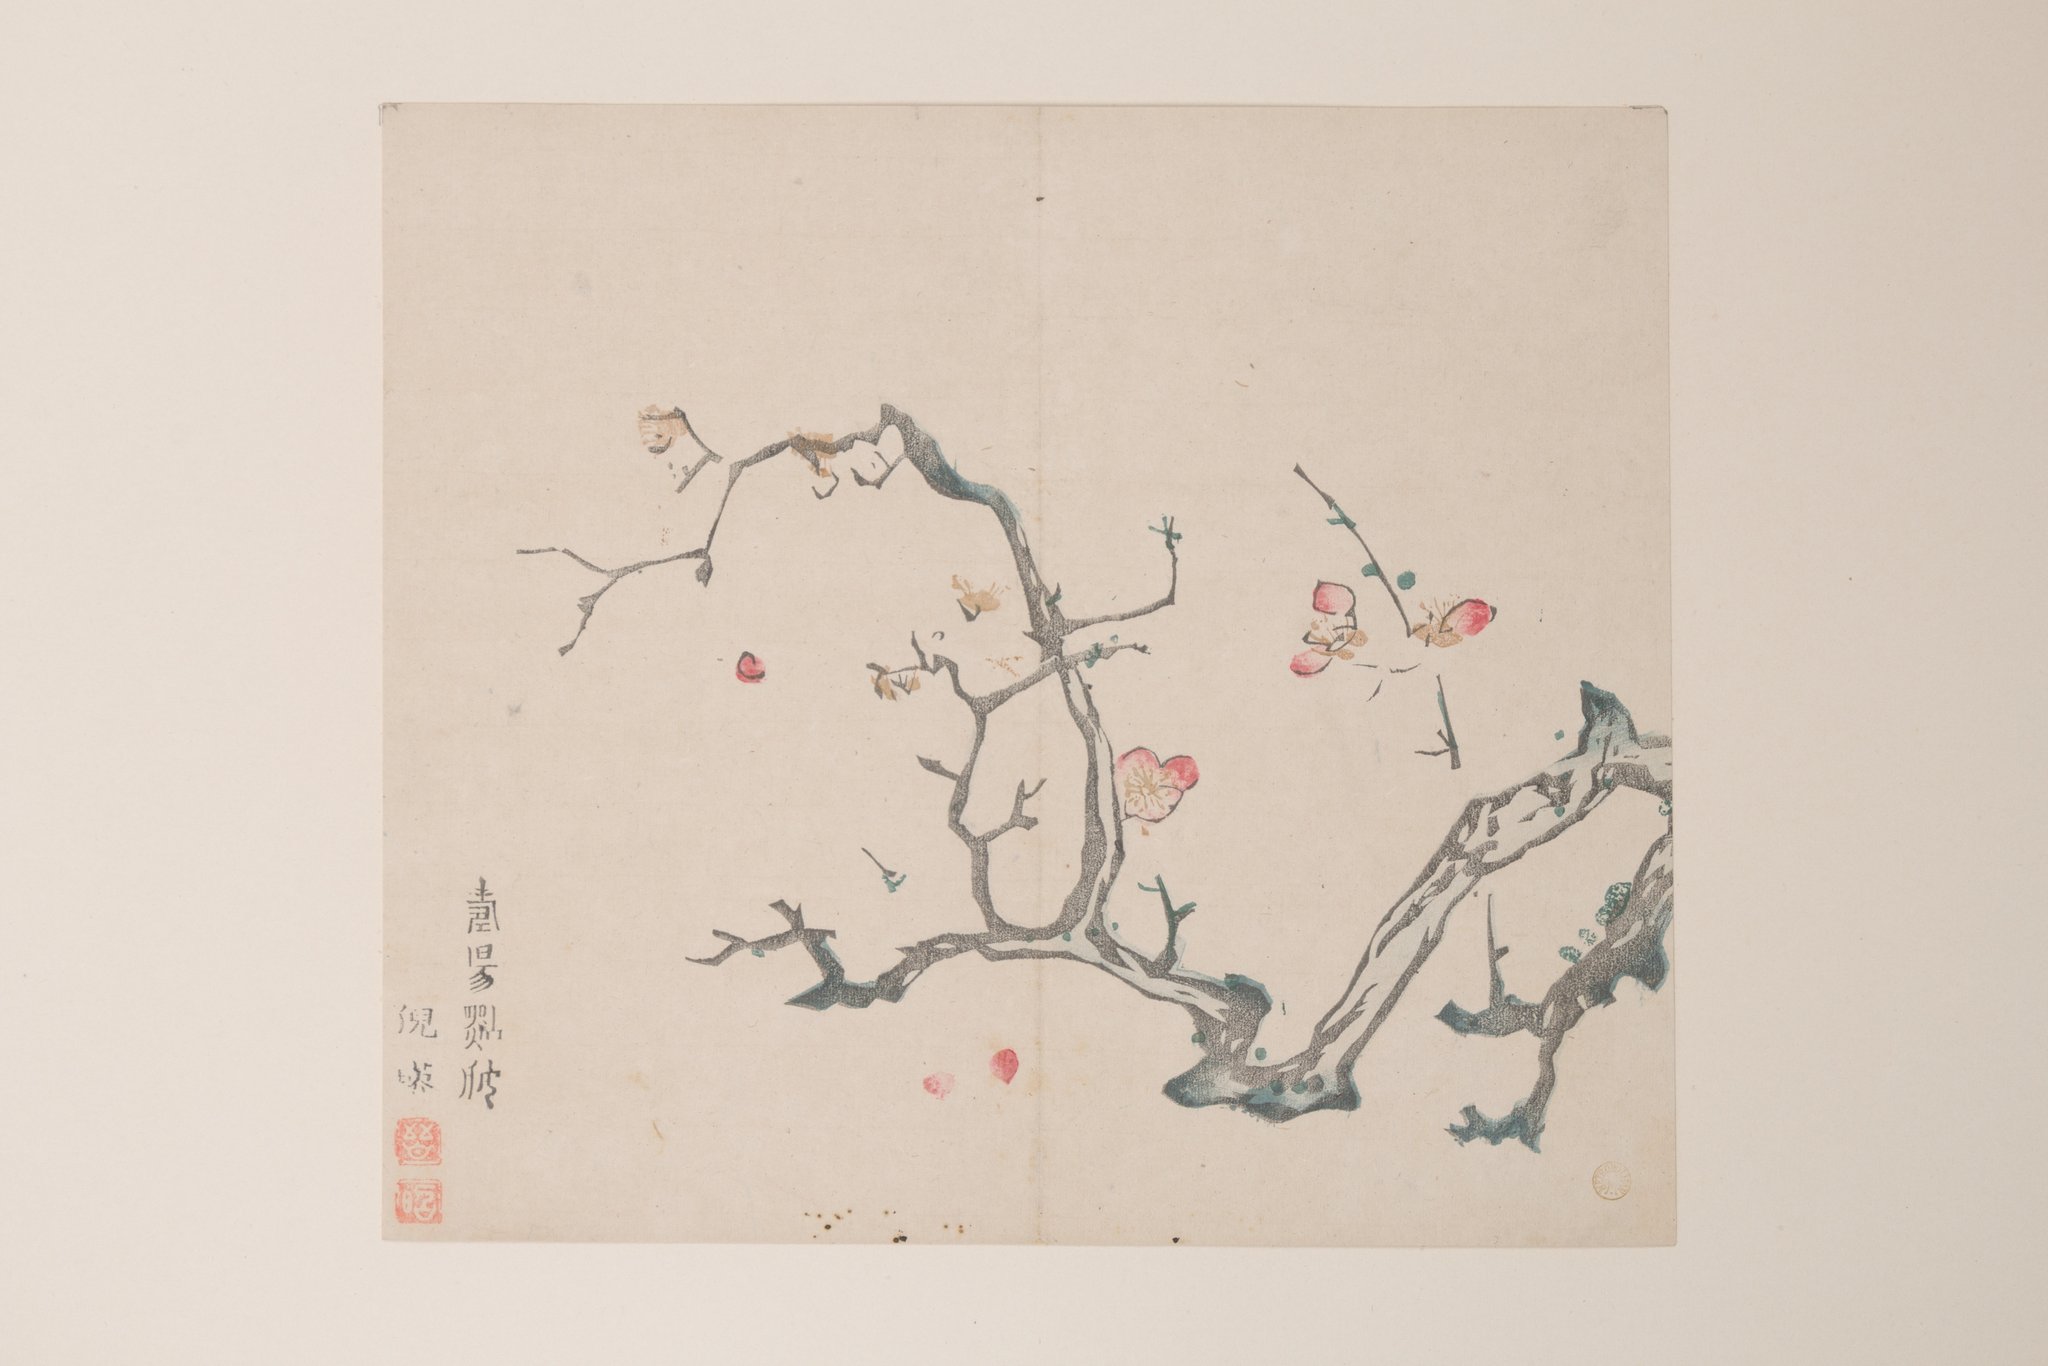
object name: print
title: Page from Shi Zhu Zhai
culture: chinese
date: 1662-1722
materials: ink, paper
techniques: polychrome, woodblock print